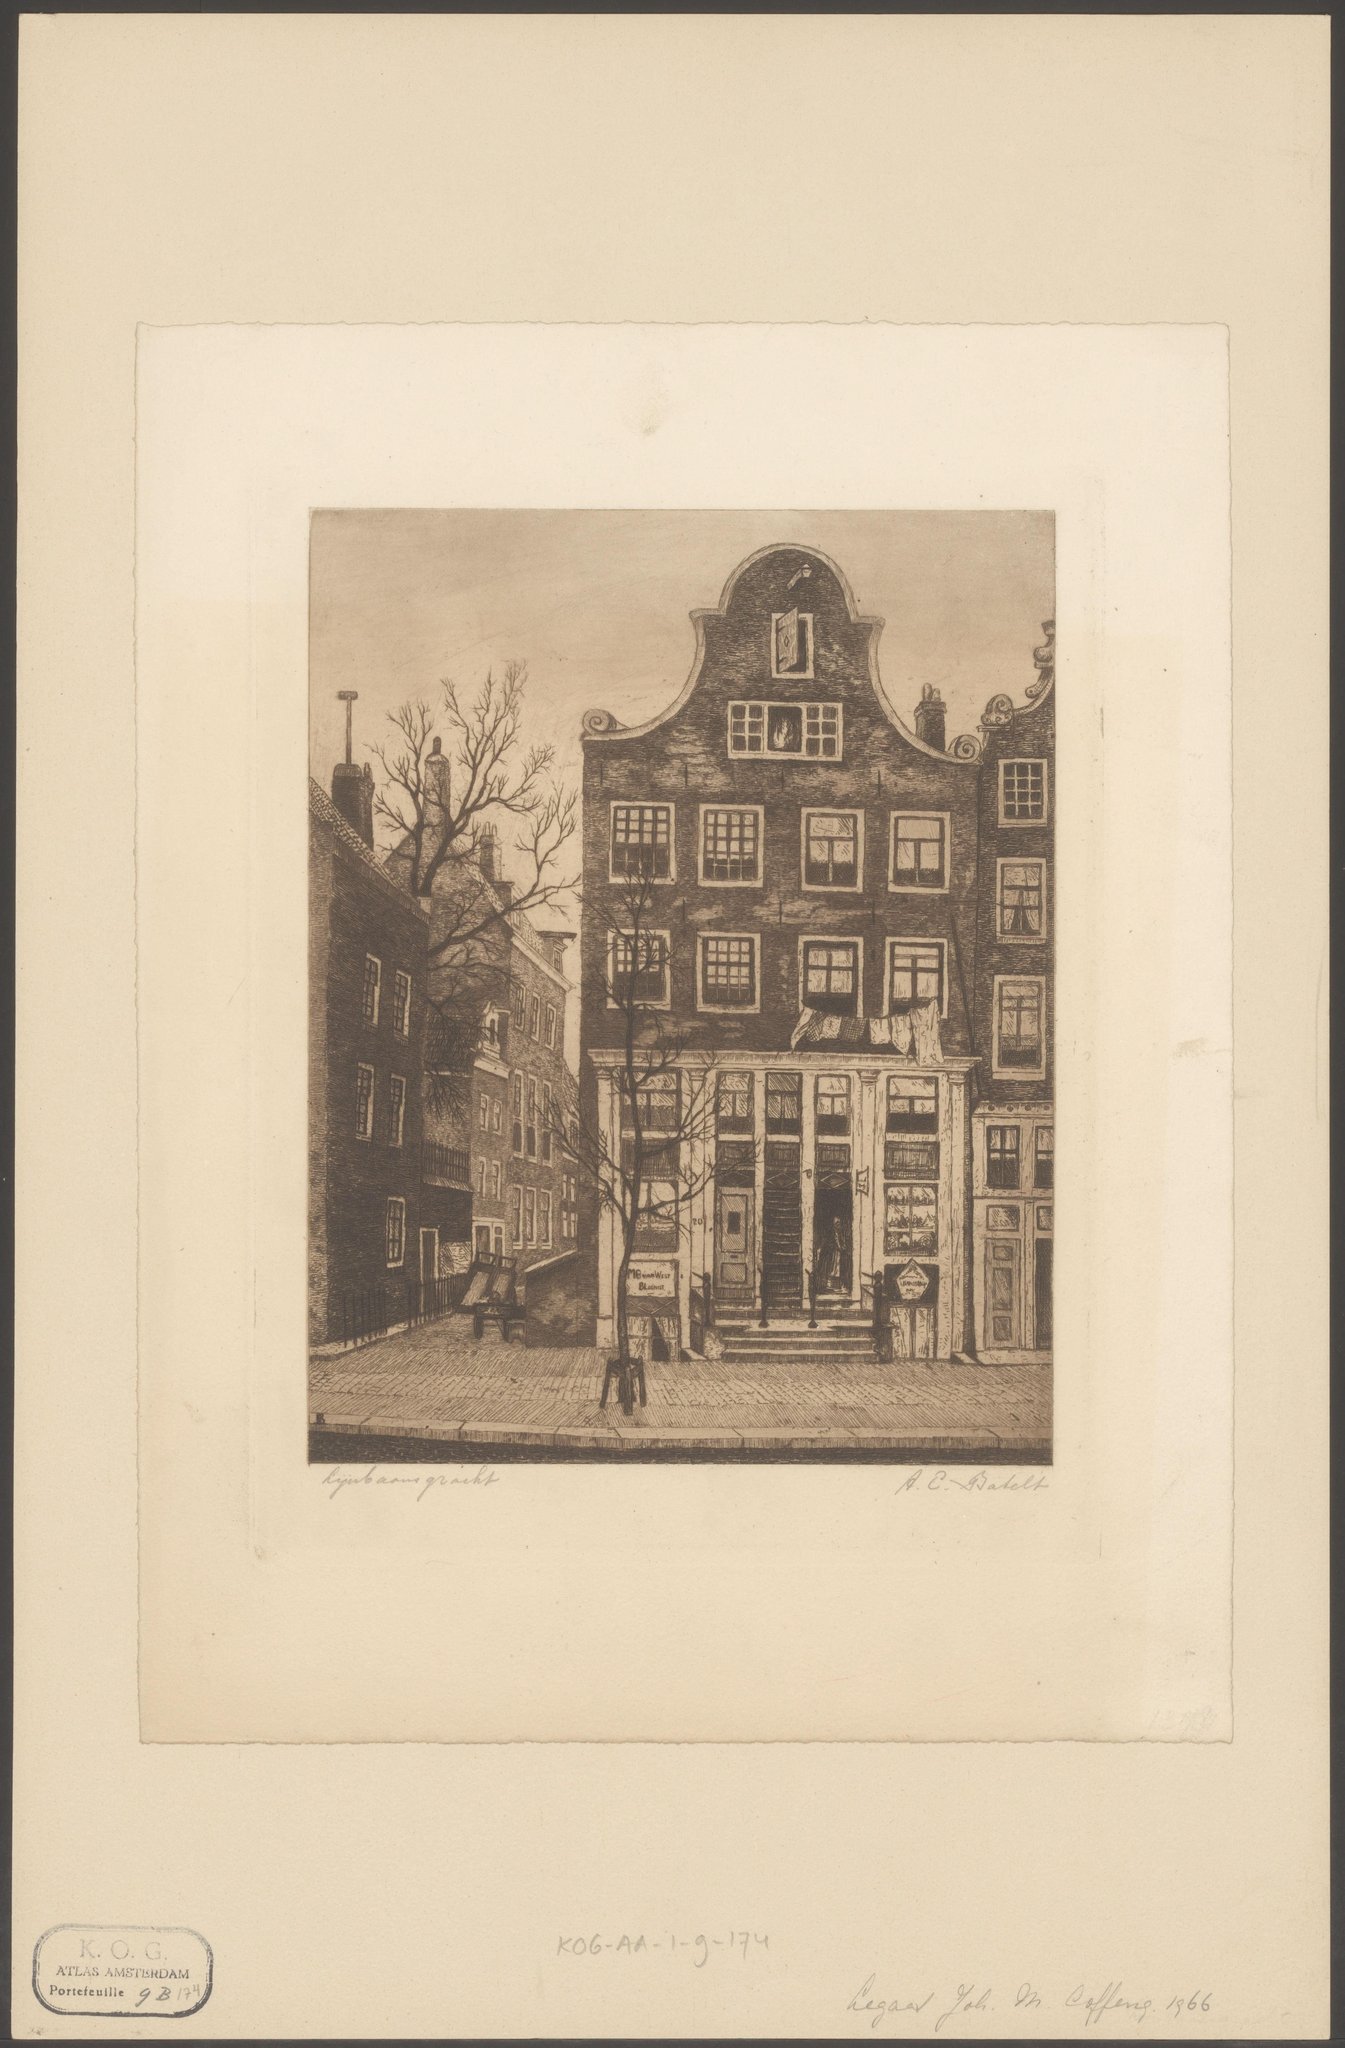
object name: print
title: Gezicht op de Lijnbaansgracht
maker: anna elisabeth batelt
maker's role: draughtsman, painter, print maker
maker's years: 1869-1921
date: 1879-1950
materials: paper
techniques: drypoint, etching, intaglio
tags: city-view in general; 'veduta', canal, the usual house or row of houses, street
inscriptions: collector's mark: ‘9B174’ Lugt 1641b, signature: ‘Lijnbaansgracht / A.E. Batelt’, inscription: ‘Legaat Joh. M. Coffeng. 1966’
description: Onderwerpsrubriek binnen de Atlas Amsterdam: 2e Laurierdwarsstraat (Vuile Weespad), Leidschegracht, Leidschekade, Leidscheplein, Leidschestraat, v. Lennepkade, Lijnbaansgracht, Lauriergracht, Leliedwarsstraat, Leliegracht, Lindengracht, Lombardsteeg, Looiersgracht, Looiersstraat (Nieuwe), Leidekkerssteeg.